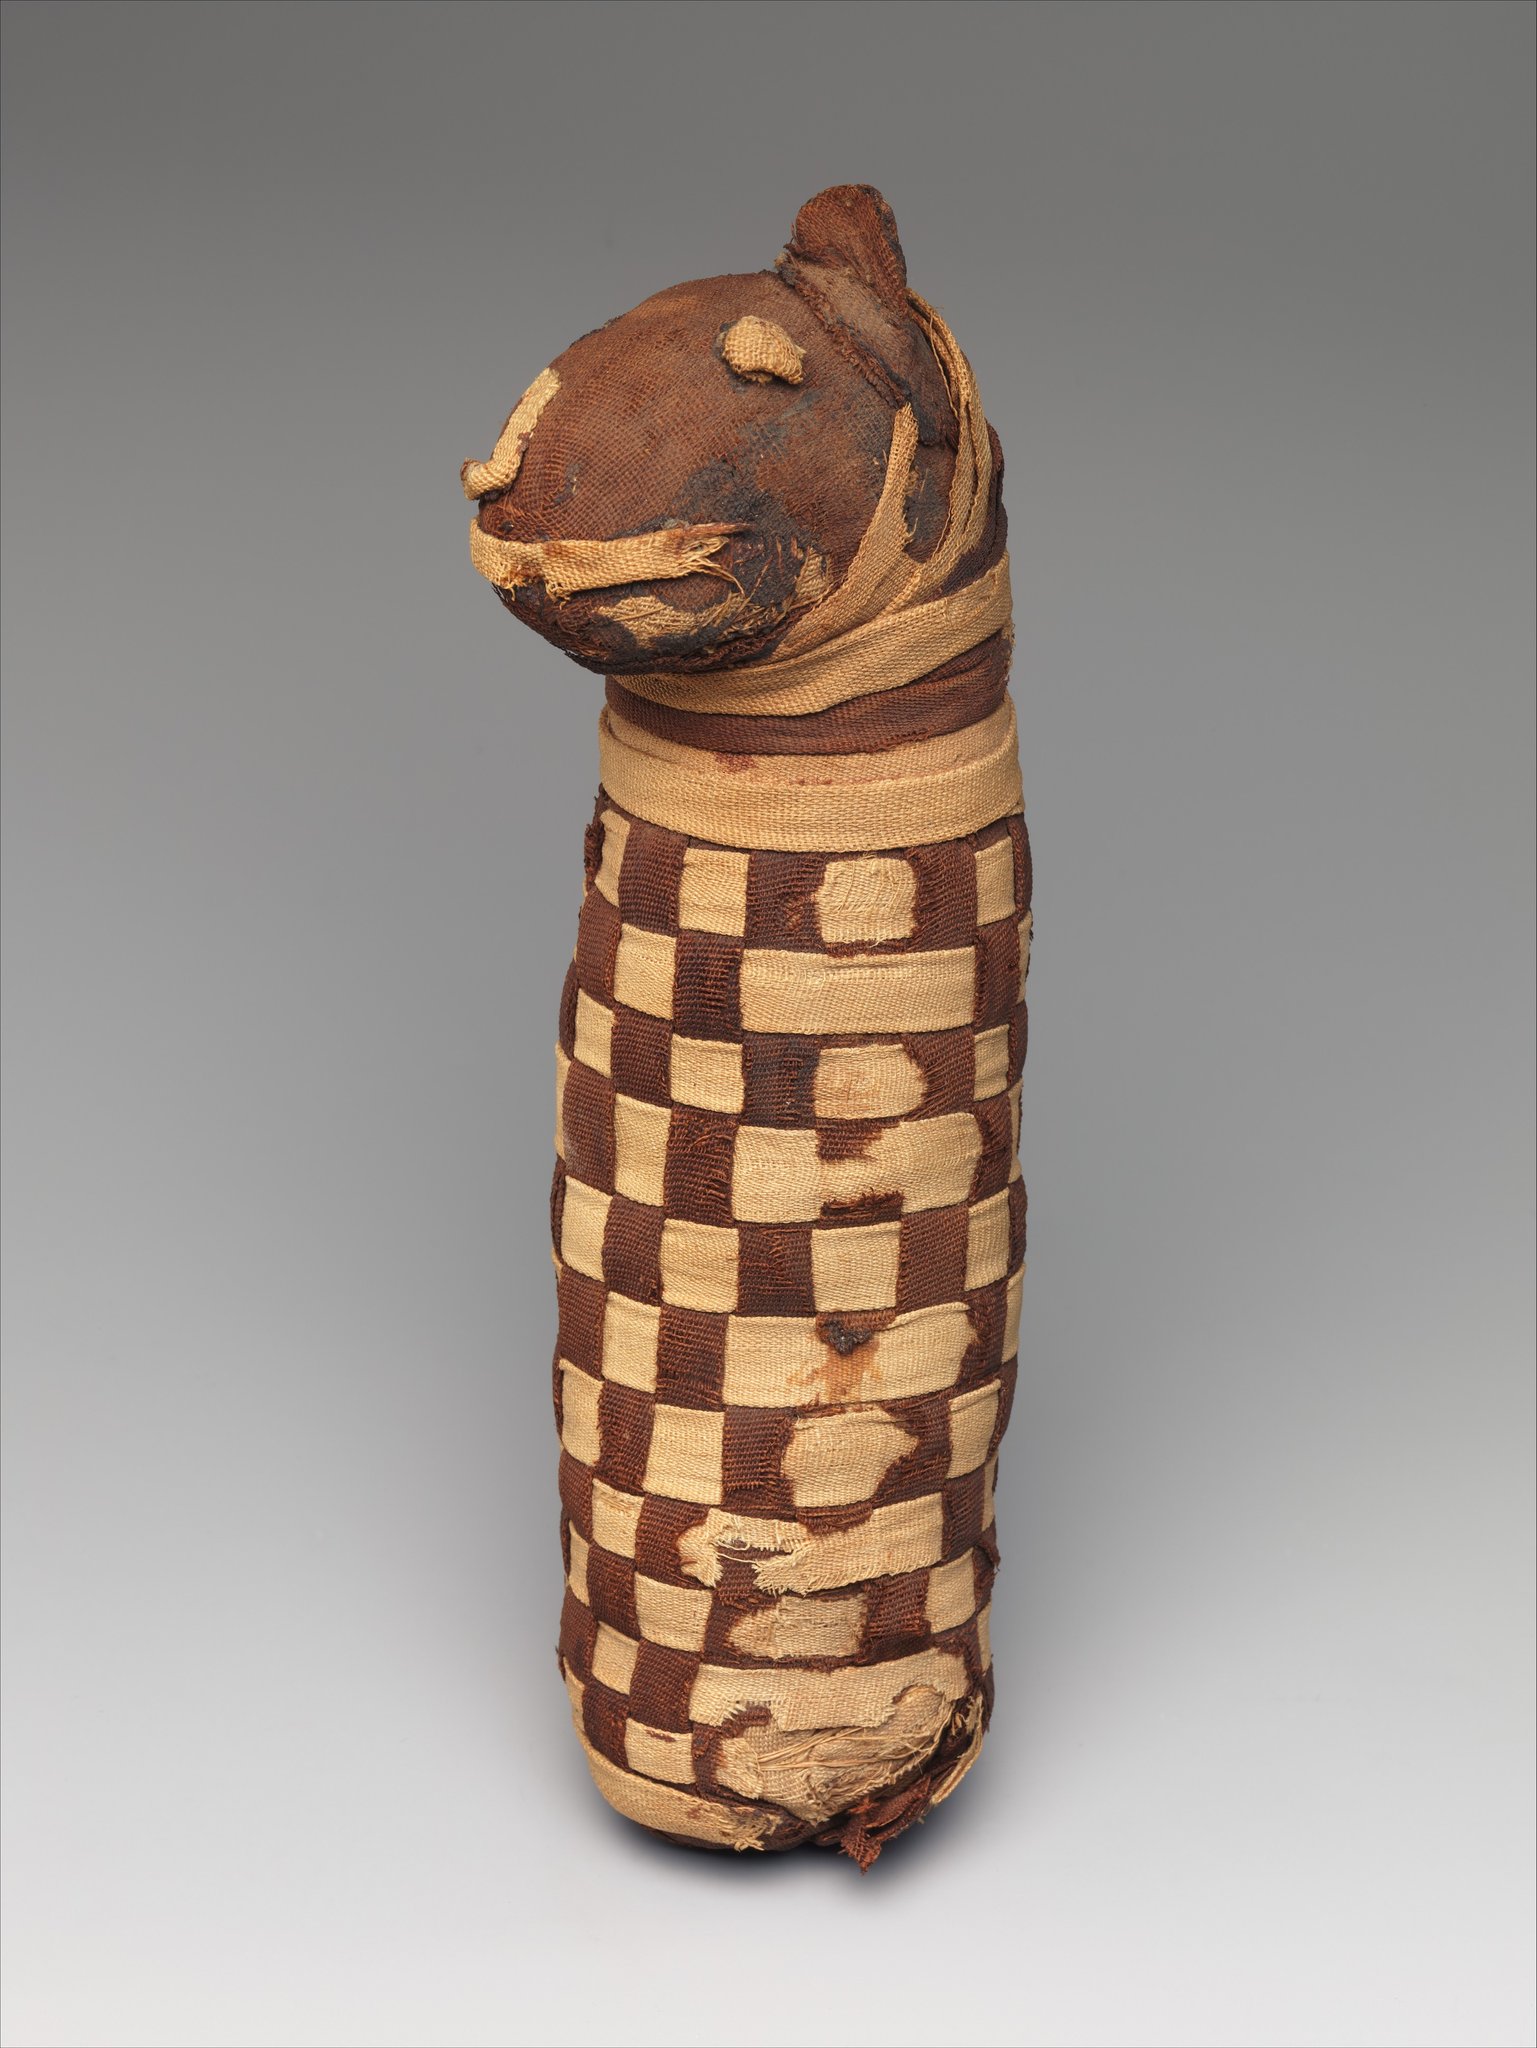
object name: mummy, dog bone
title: Sacred animal mummy containing dog bones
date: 400 BCE-100 CE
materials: linen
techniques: dyeing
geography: egypt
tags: animals,mummies